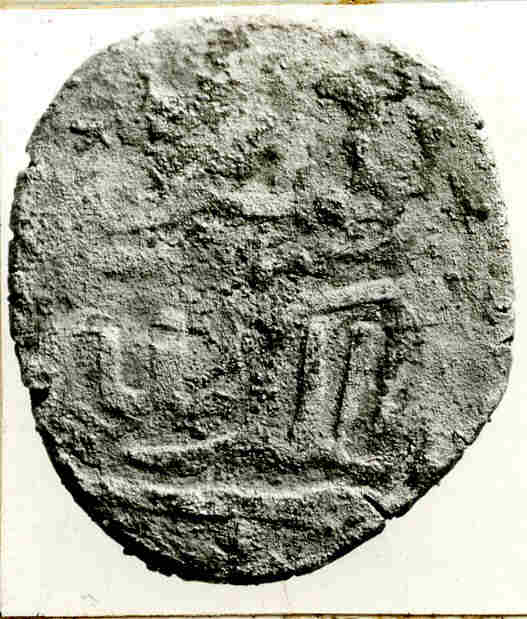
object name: coin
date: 1201-1400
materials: copper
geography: iran